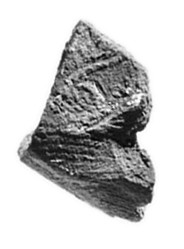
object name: sealing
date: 1981-1640 BCE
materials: mud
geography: egypt